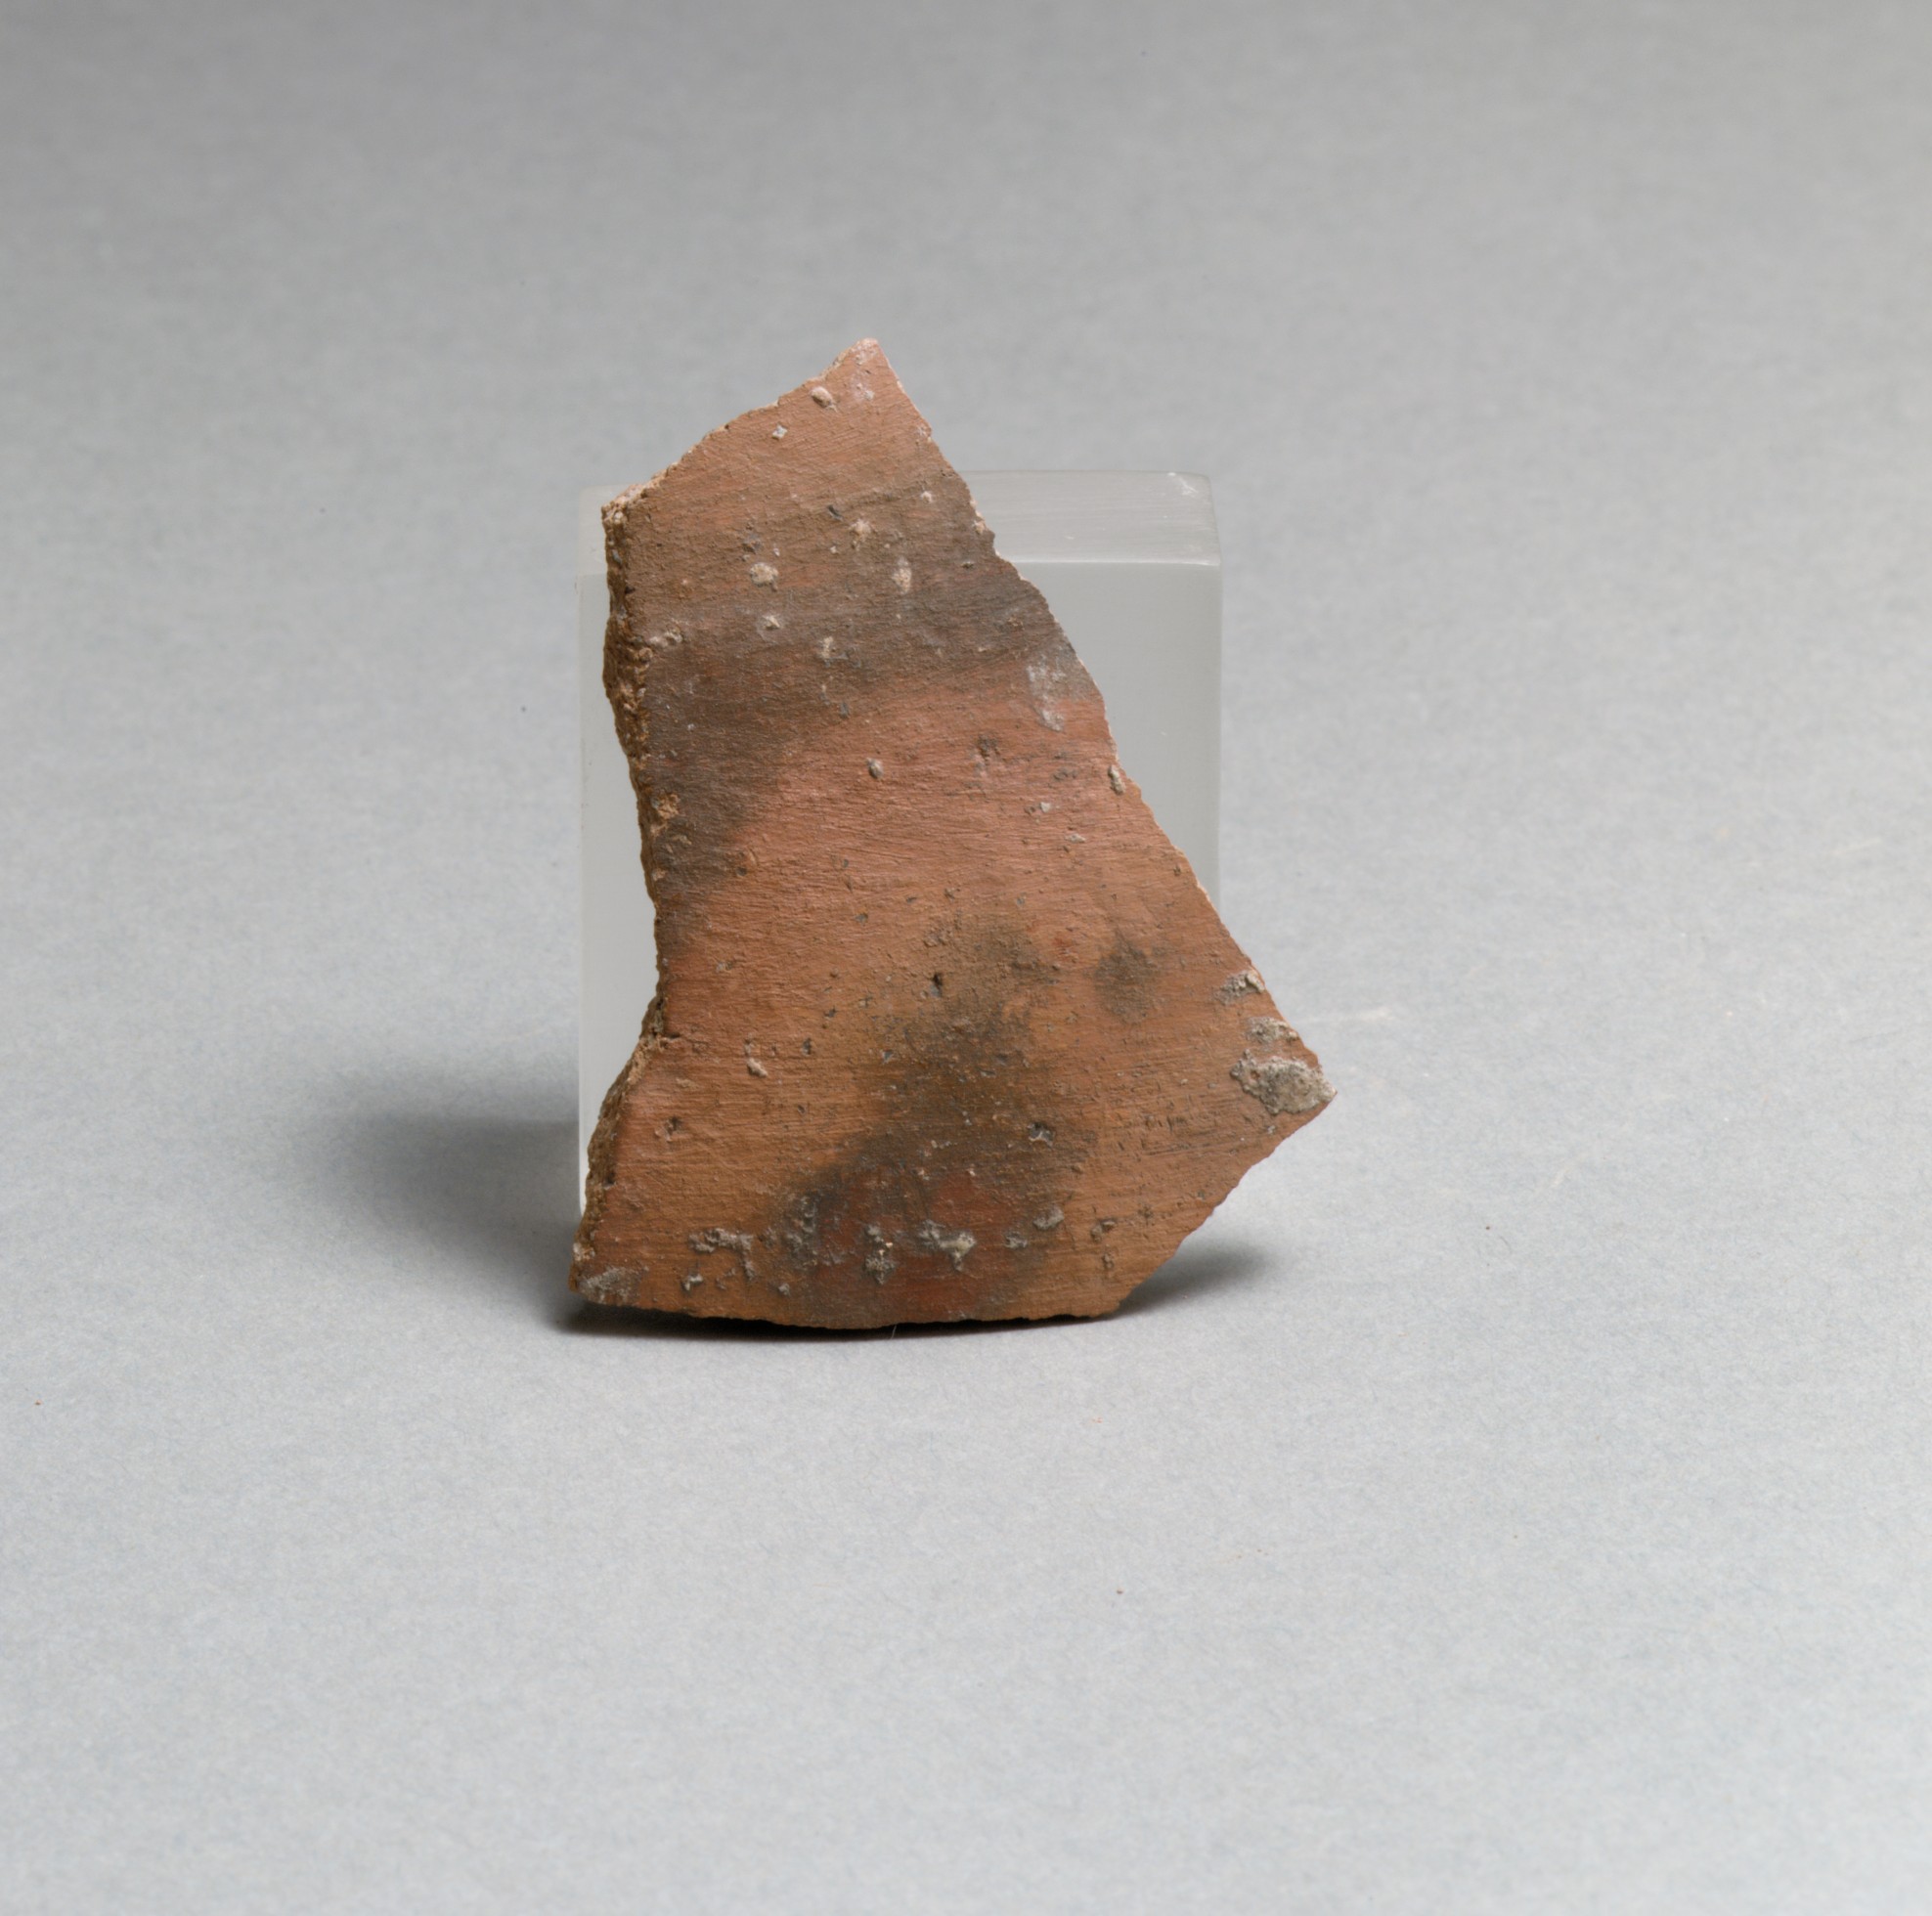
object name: vase fragment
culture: minoan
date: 2600-2000 BCE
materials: terracotta